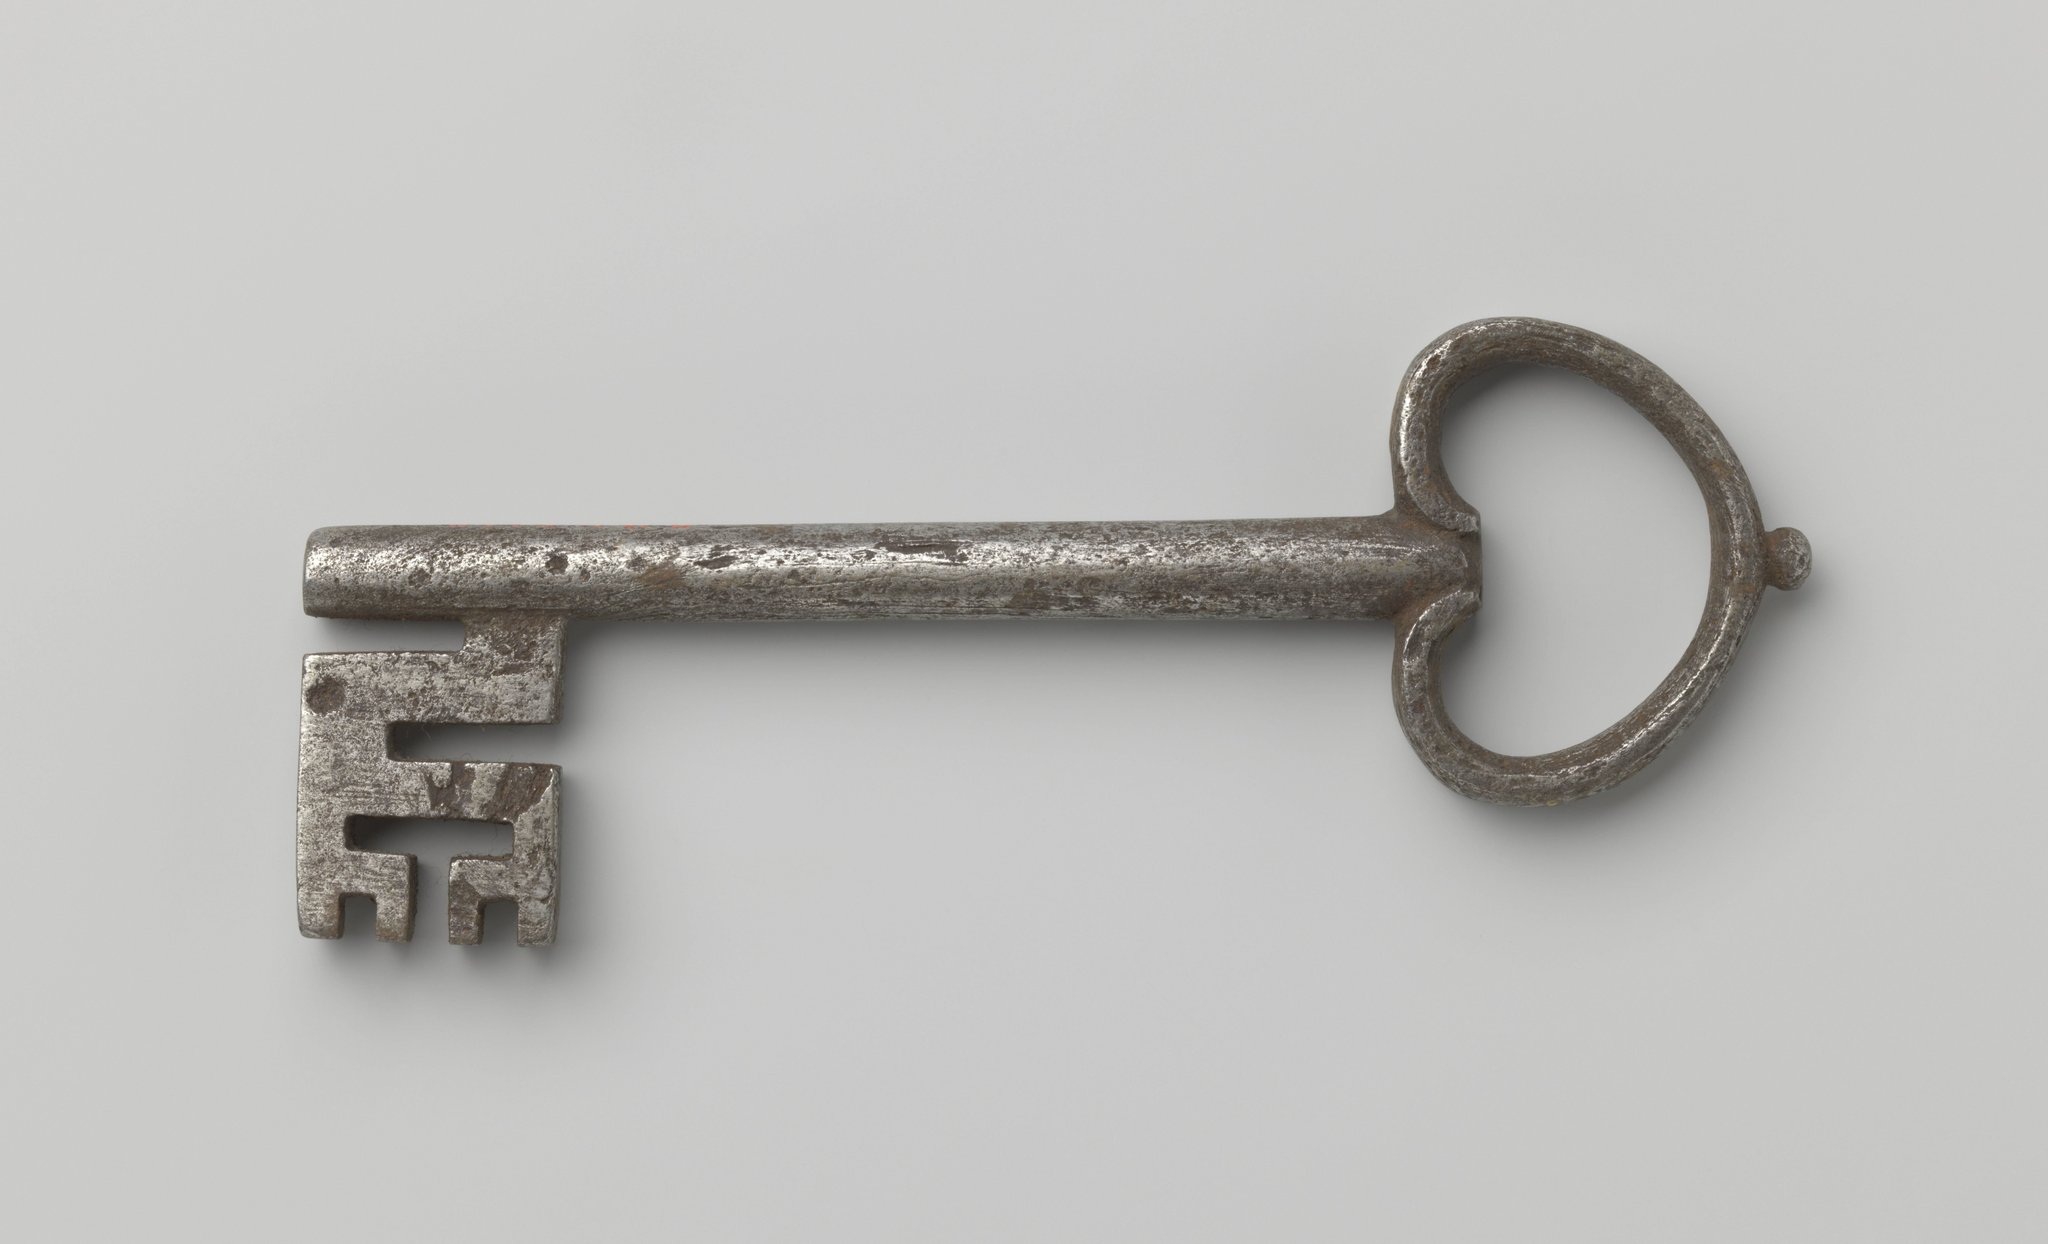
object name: key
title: Sleutel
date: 1600-1699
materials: iron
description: Sleutel met boonvormig oog, waarop een knopje.